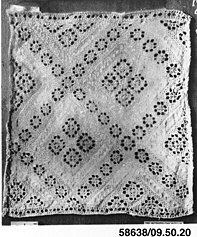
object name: square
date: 1801-1900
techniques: embroidery